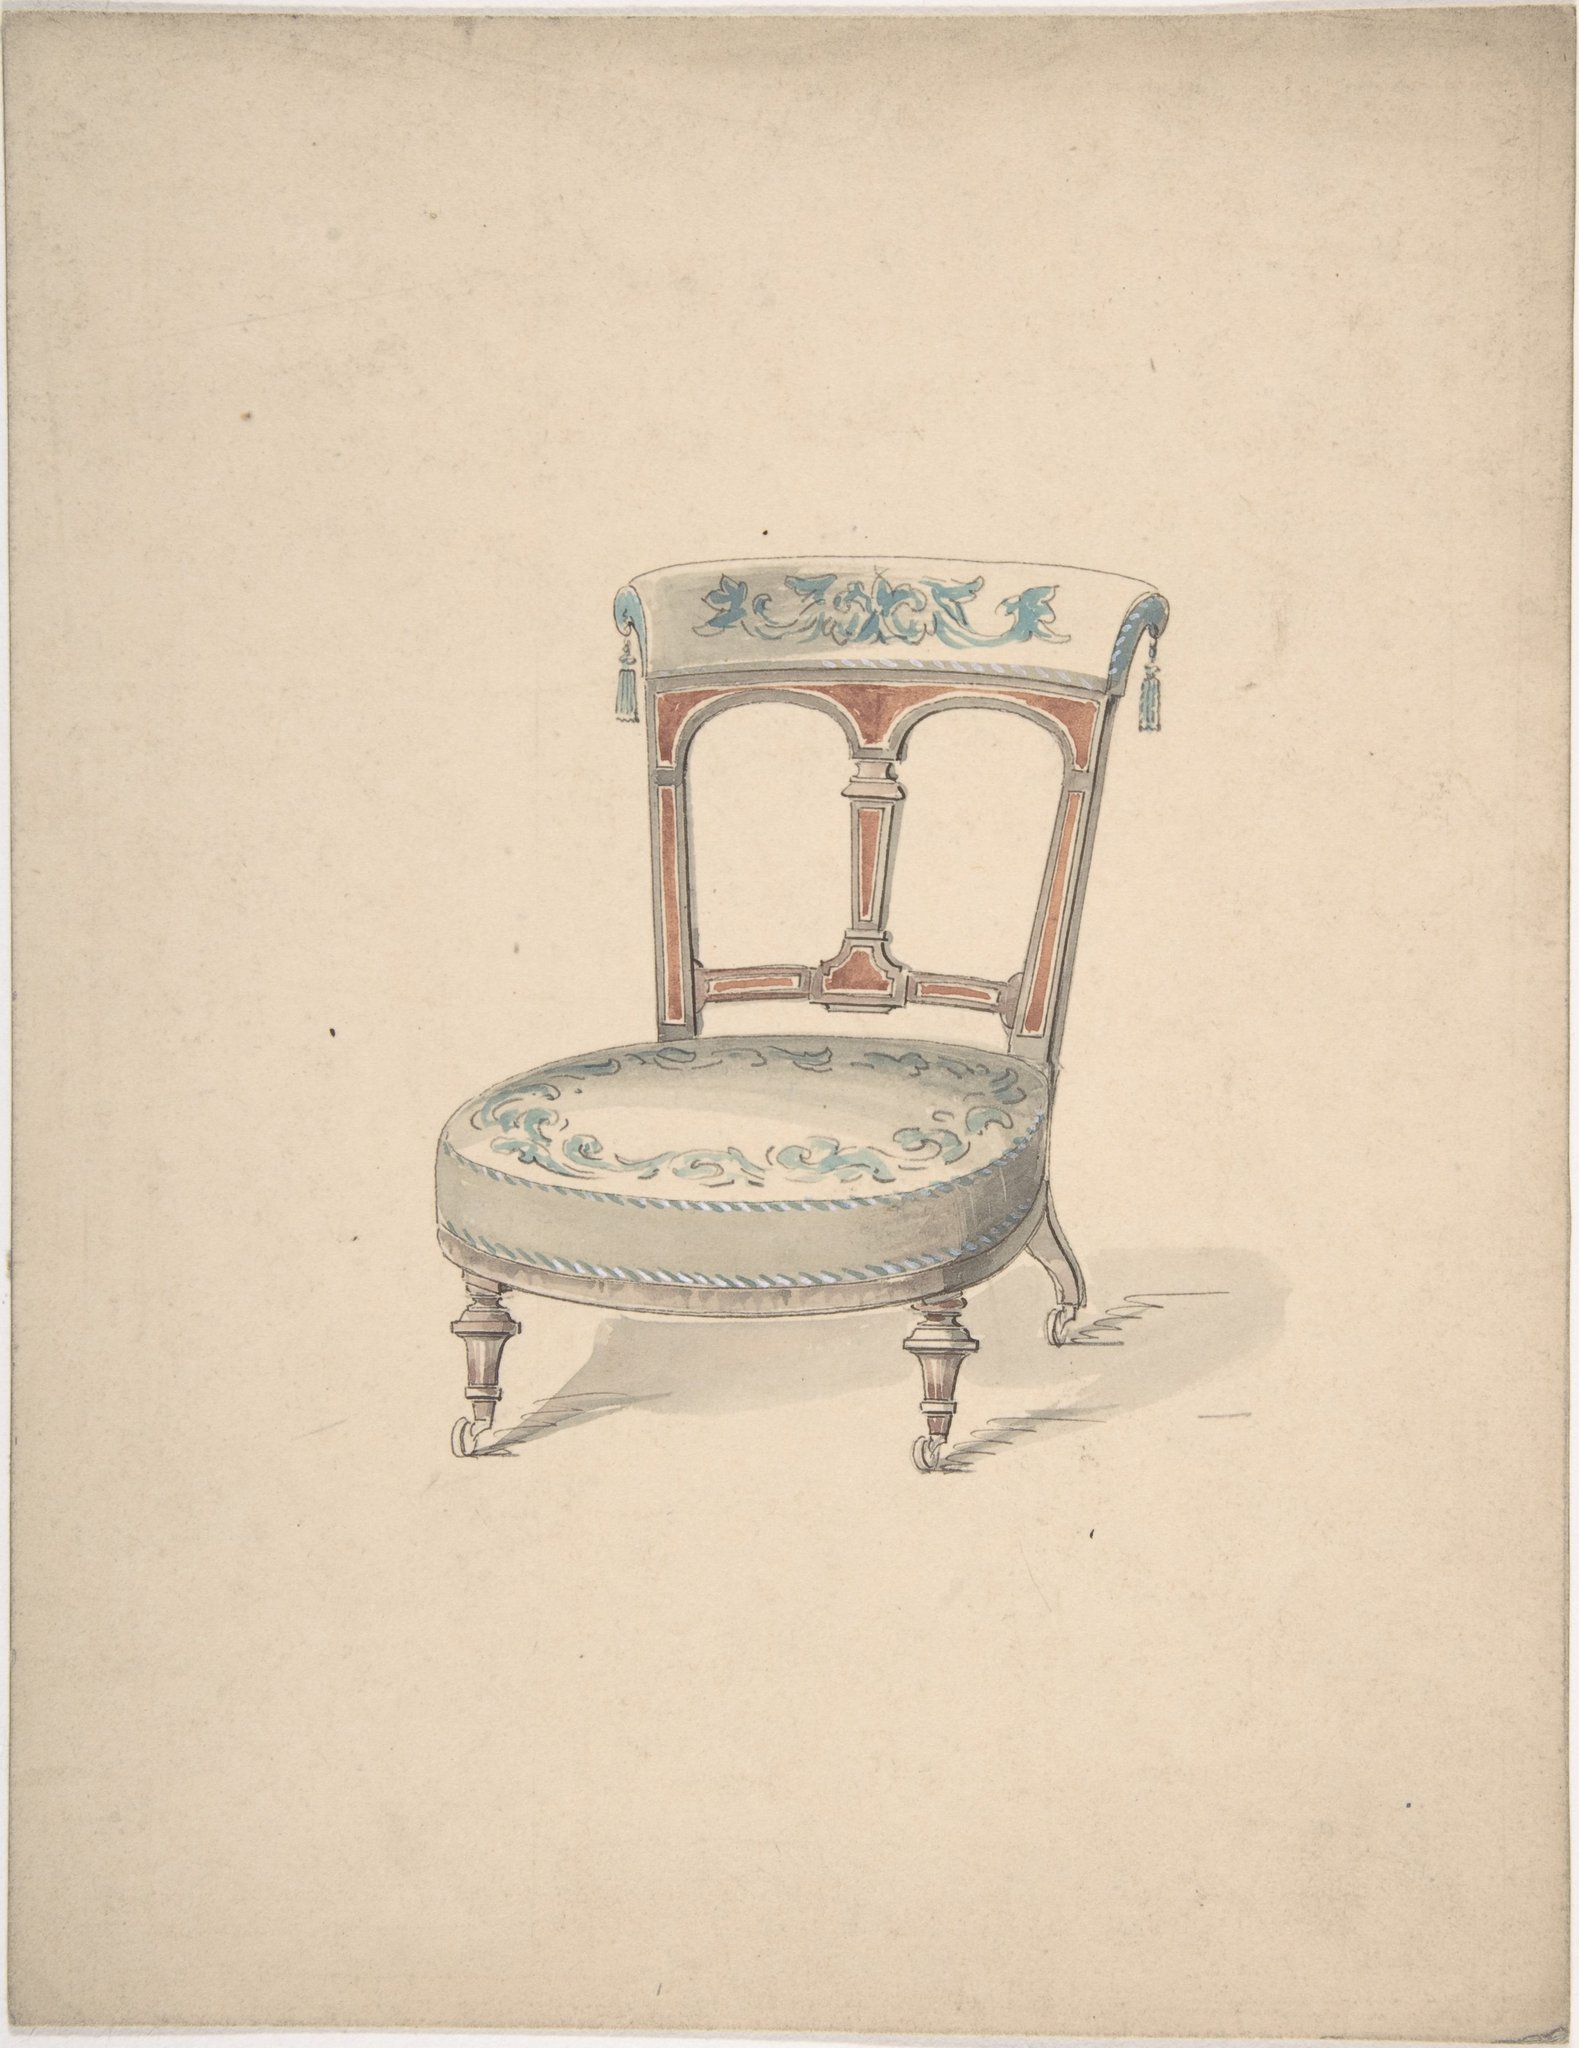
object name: drawing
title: Design for a Low Chair on Casters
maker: anonymous, british, 19th century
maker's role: artist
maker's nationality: british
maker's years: 1800-1900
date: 1840-1899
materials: ink, watercolor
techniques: brush, pen, wash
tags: chairs